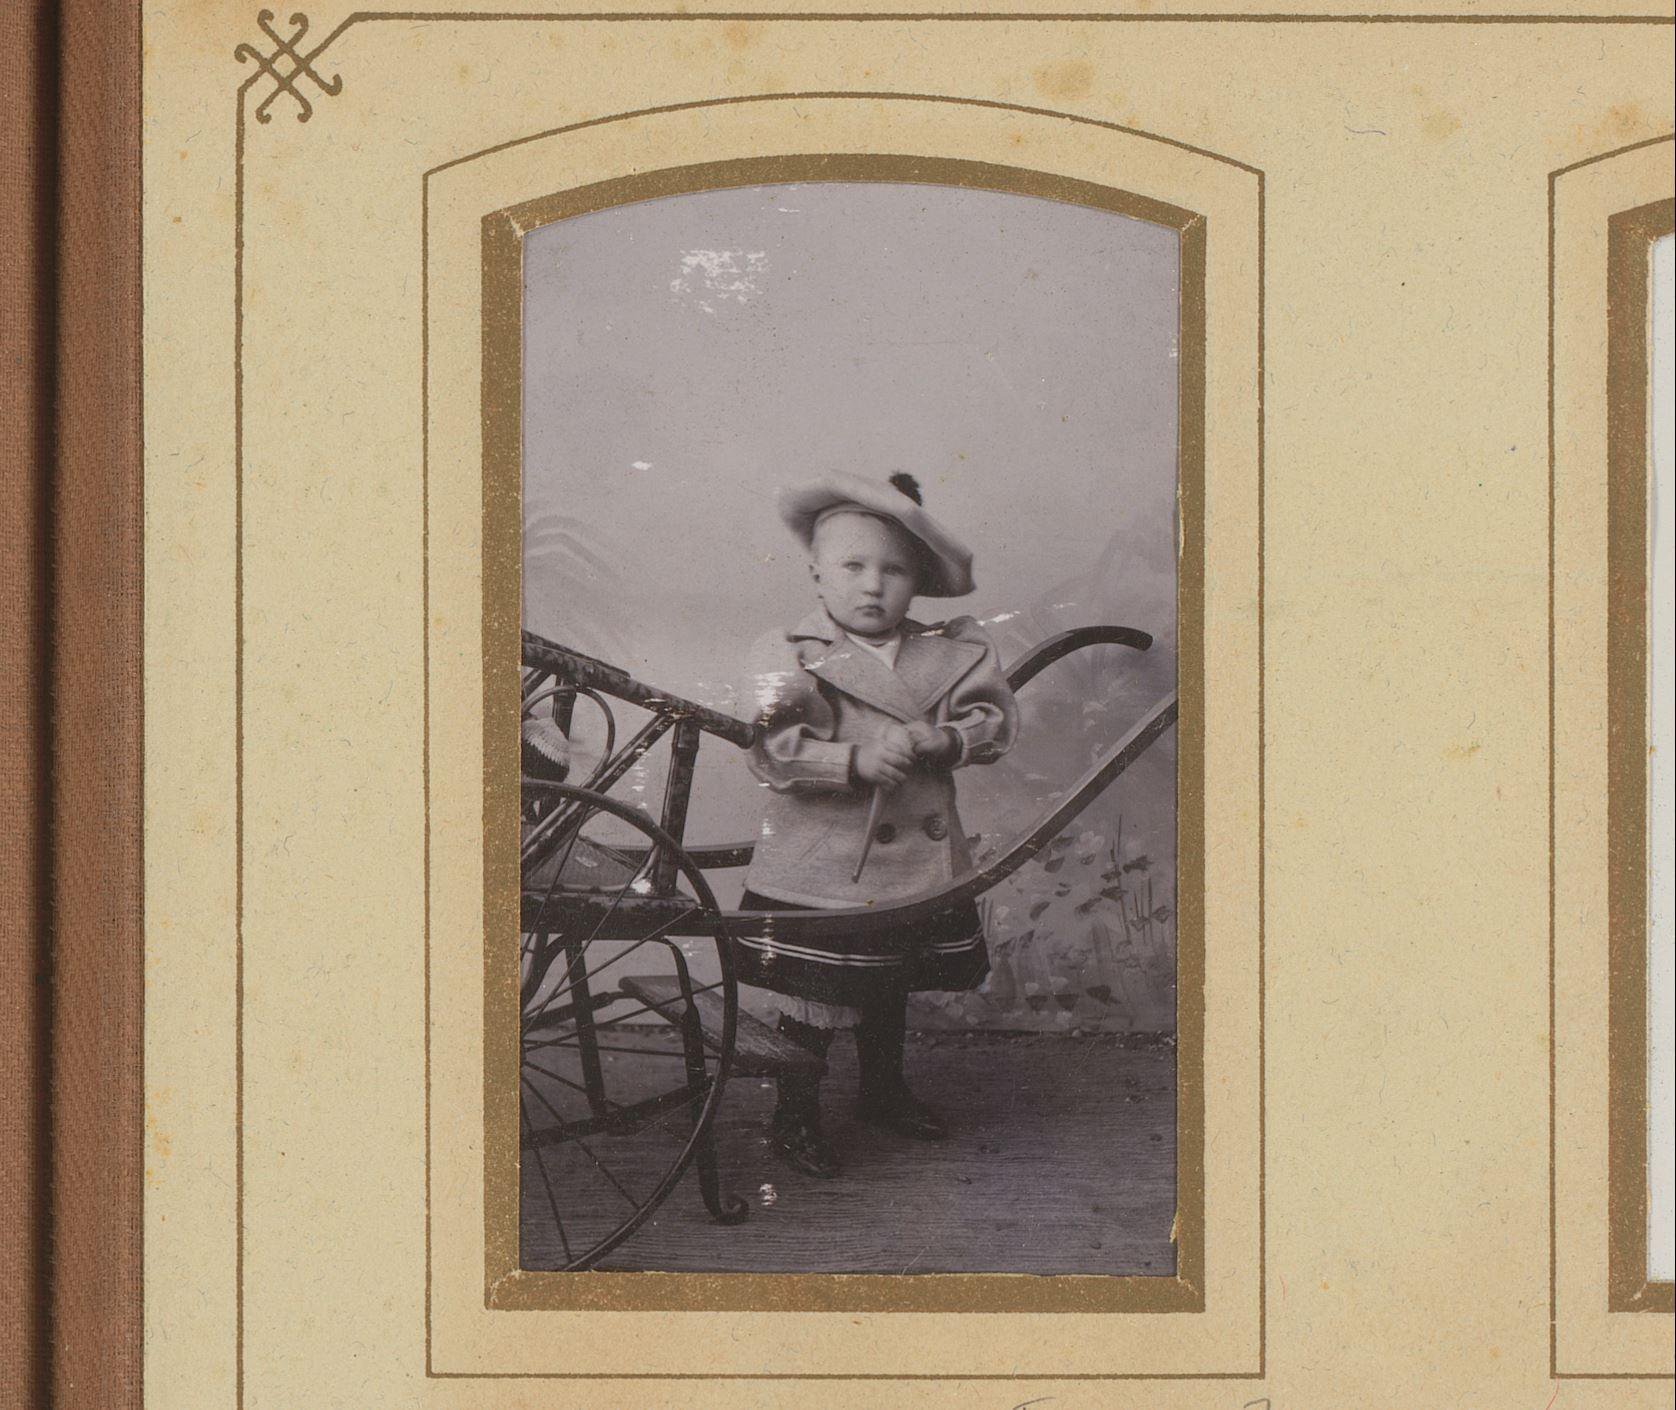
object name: album leaf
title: Portret van een kind met pet bij een kar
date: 1860-1874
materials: cardboard, photographic support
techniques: collodion silver print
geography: north holland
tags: child, head-gear: hat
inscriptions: inscription: ‘Gebrs. IJpma/ Fotografen/ Edam/ Voorhaven/ Wormerveer/ Wandelweg’